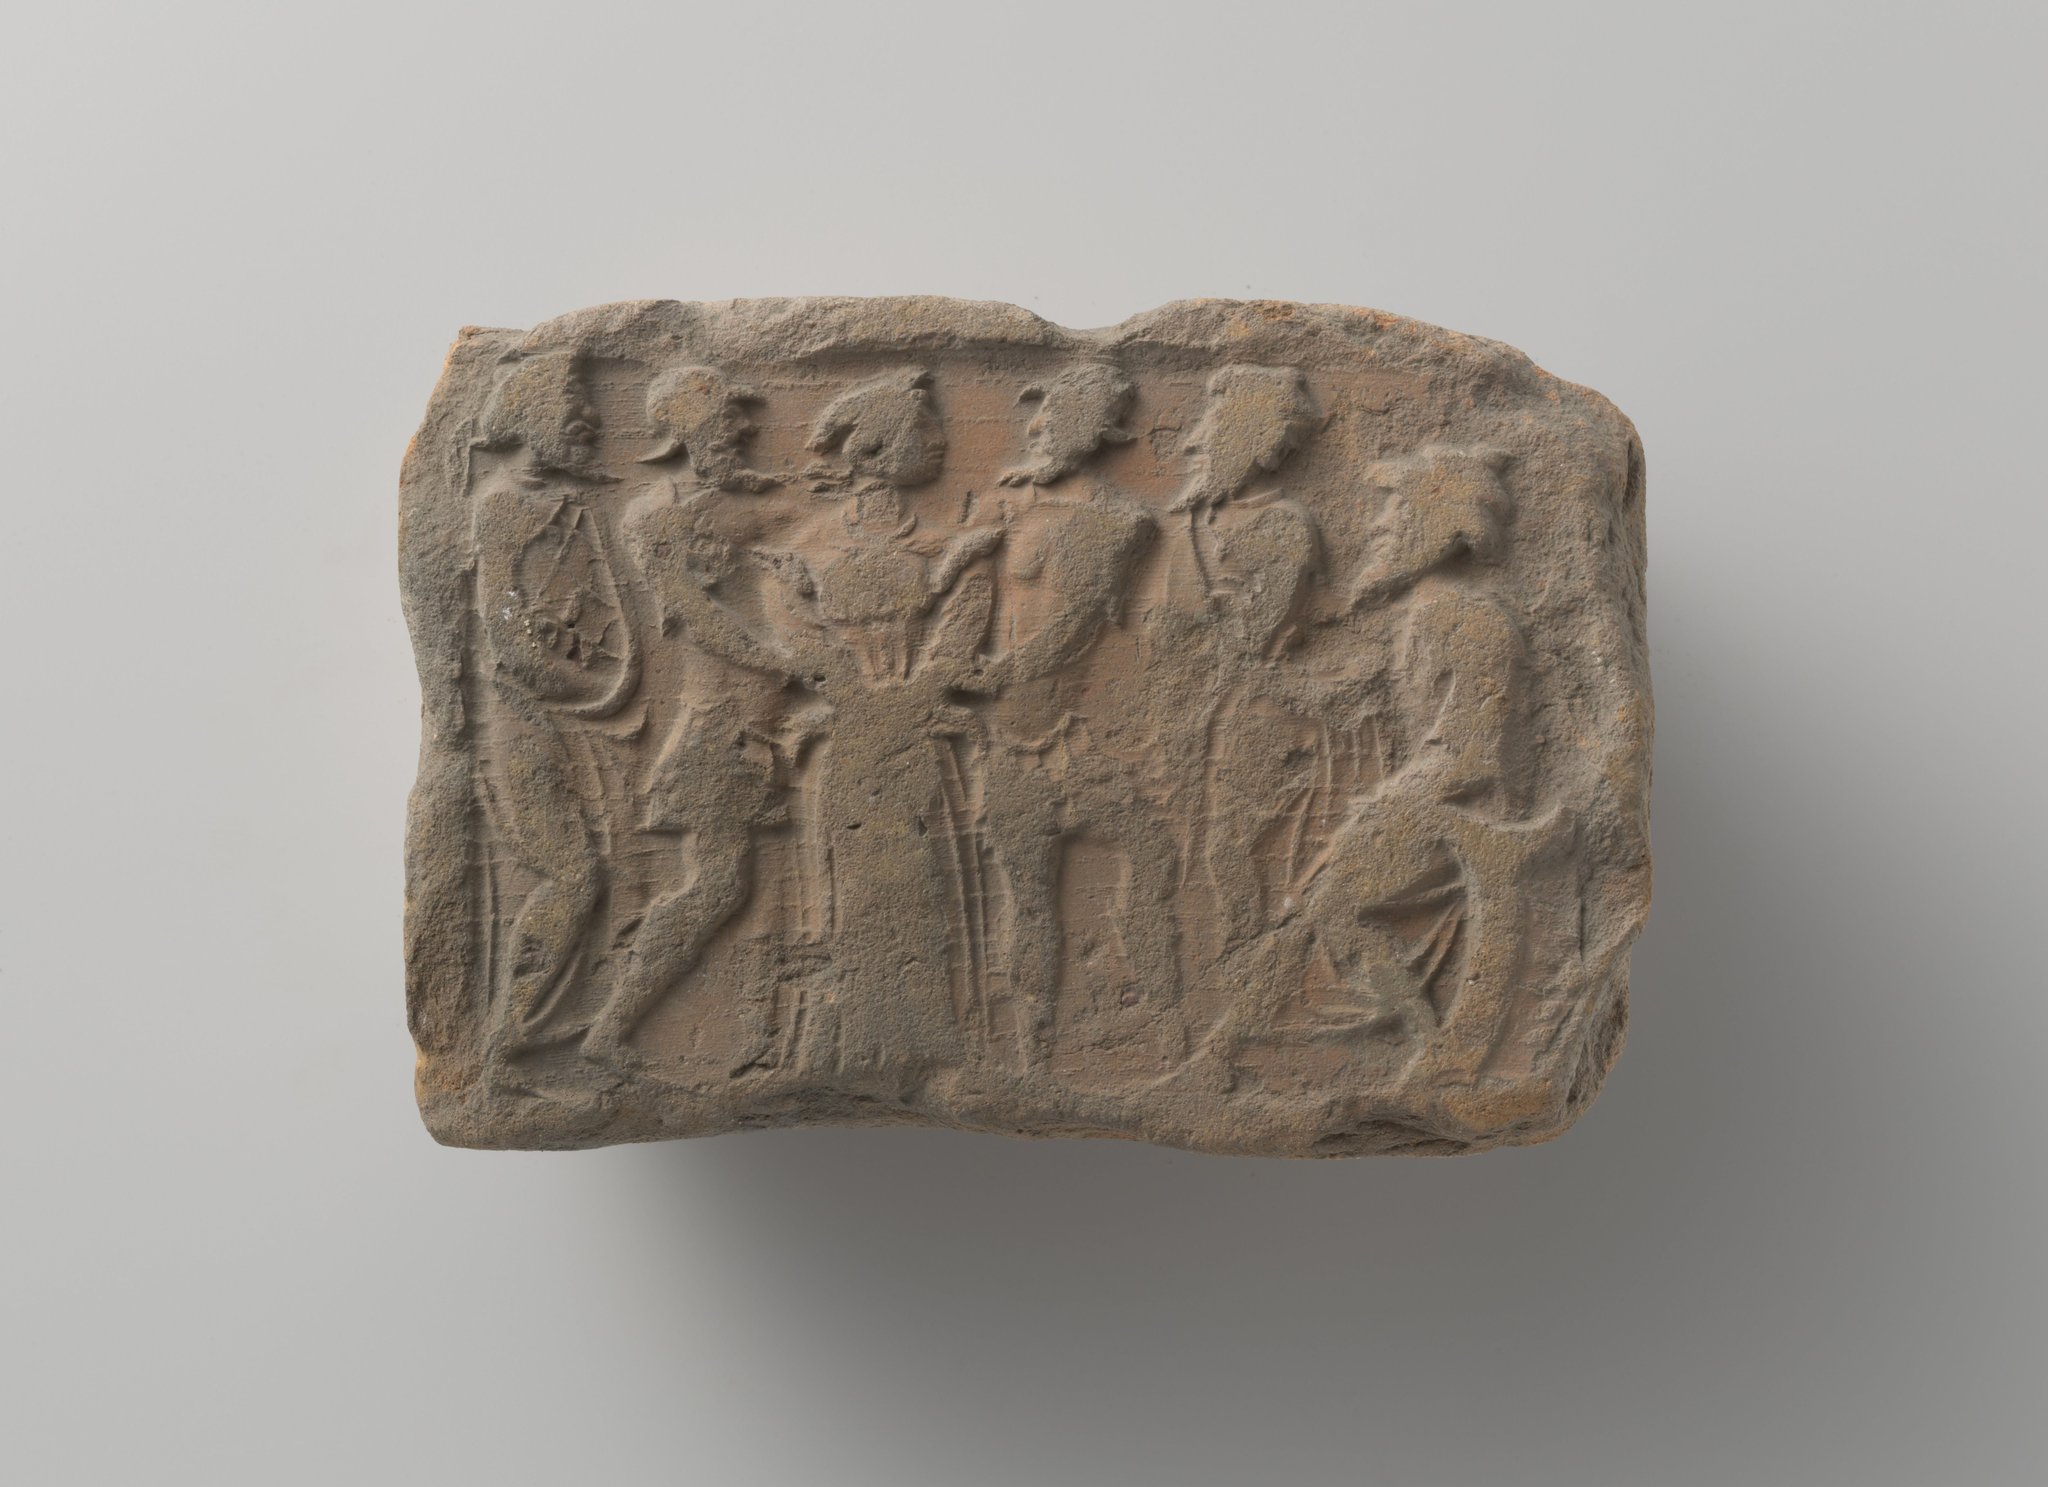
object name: hearthstone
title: Haardsteen met voorstelling van Suzanna voor de rechter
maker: Anonymous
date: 1525-1575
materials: earthenware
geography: southern netherlands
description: Haardsteen met voorstelling van Suzanna, die door de twee ouderlingen voor de rechter wordt gevoerd.